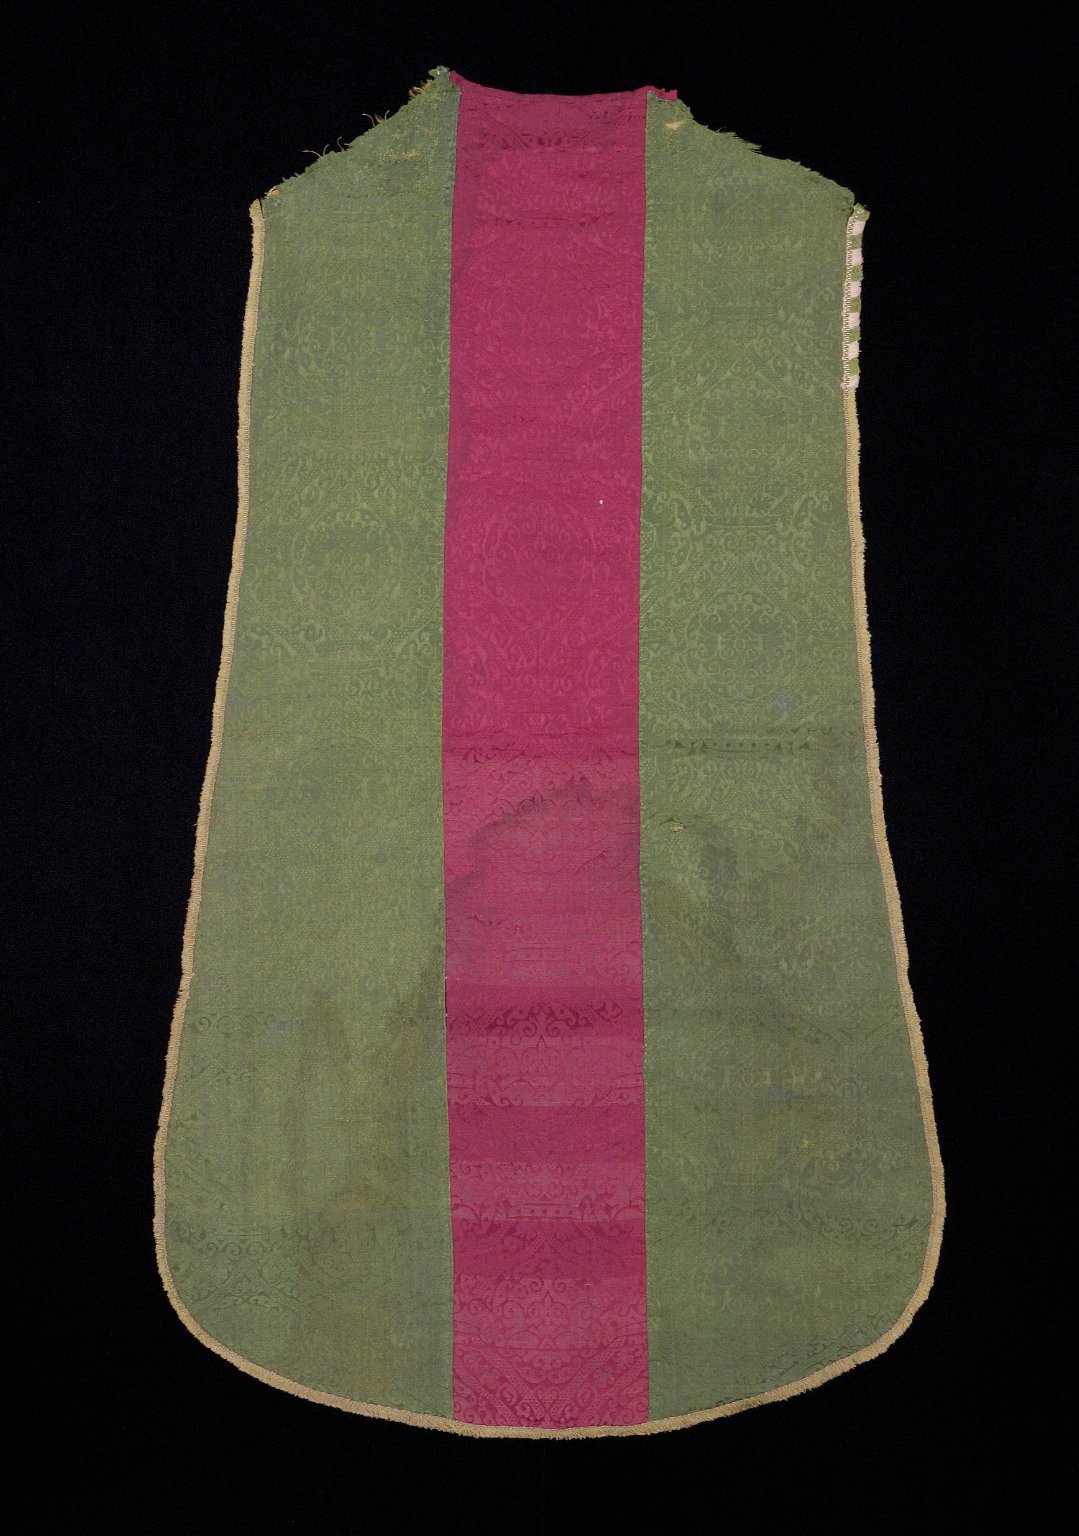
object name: chasuble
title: Chasuble back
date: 1550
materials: silk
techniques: damask